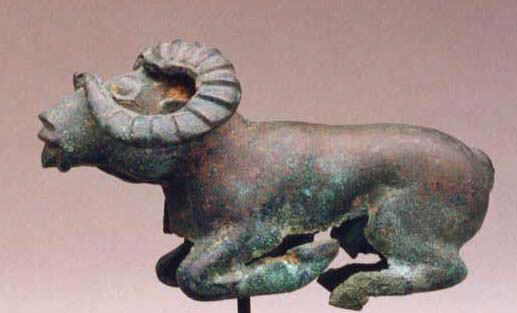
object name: chariot yoke ornament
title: Chariot Yoke Ornament in the Shape of Recumbent Ram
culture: northwest chinese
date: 500-301 BCE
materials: bronze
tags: rams